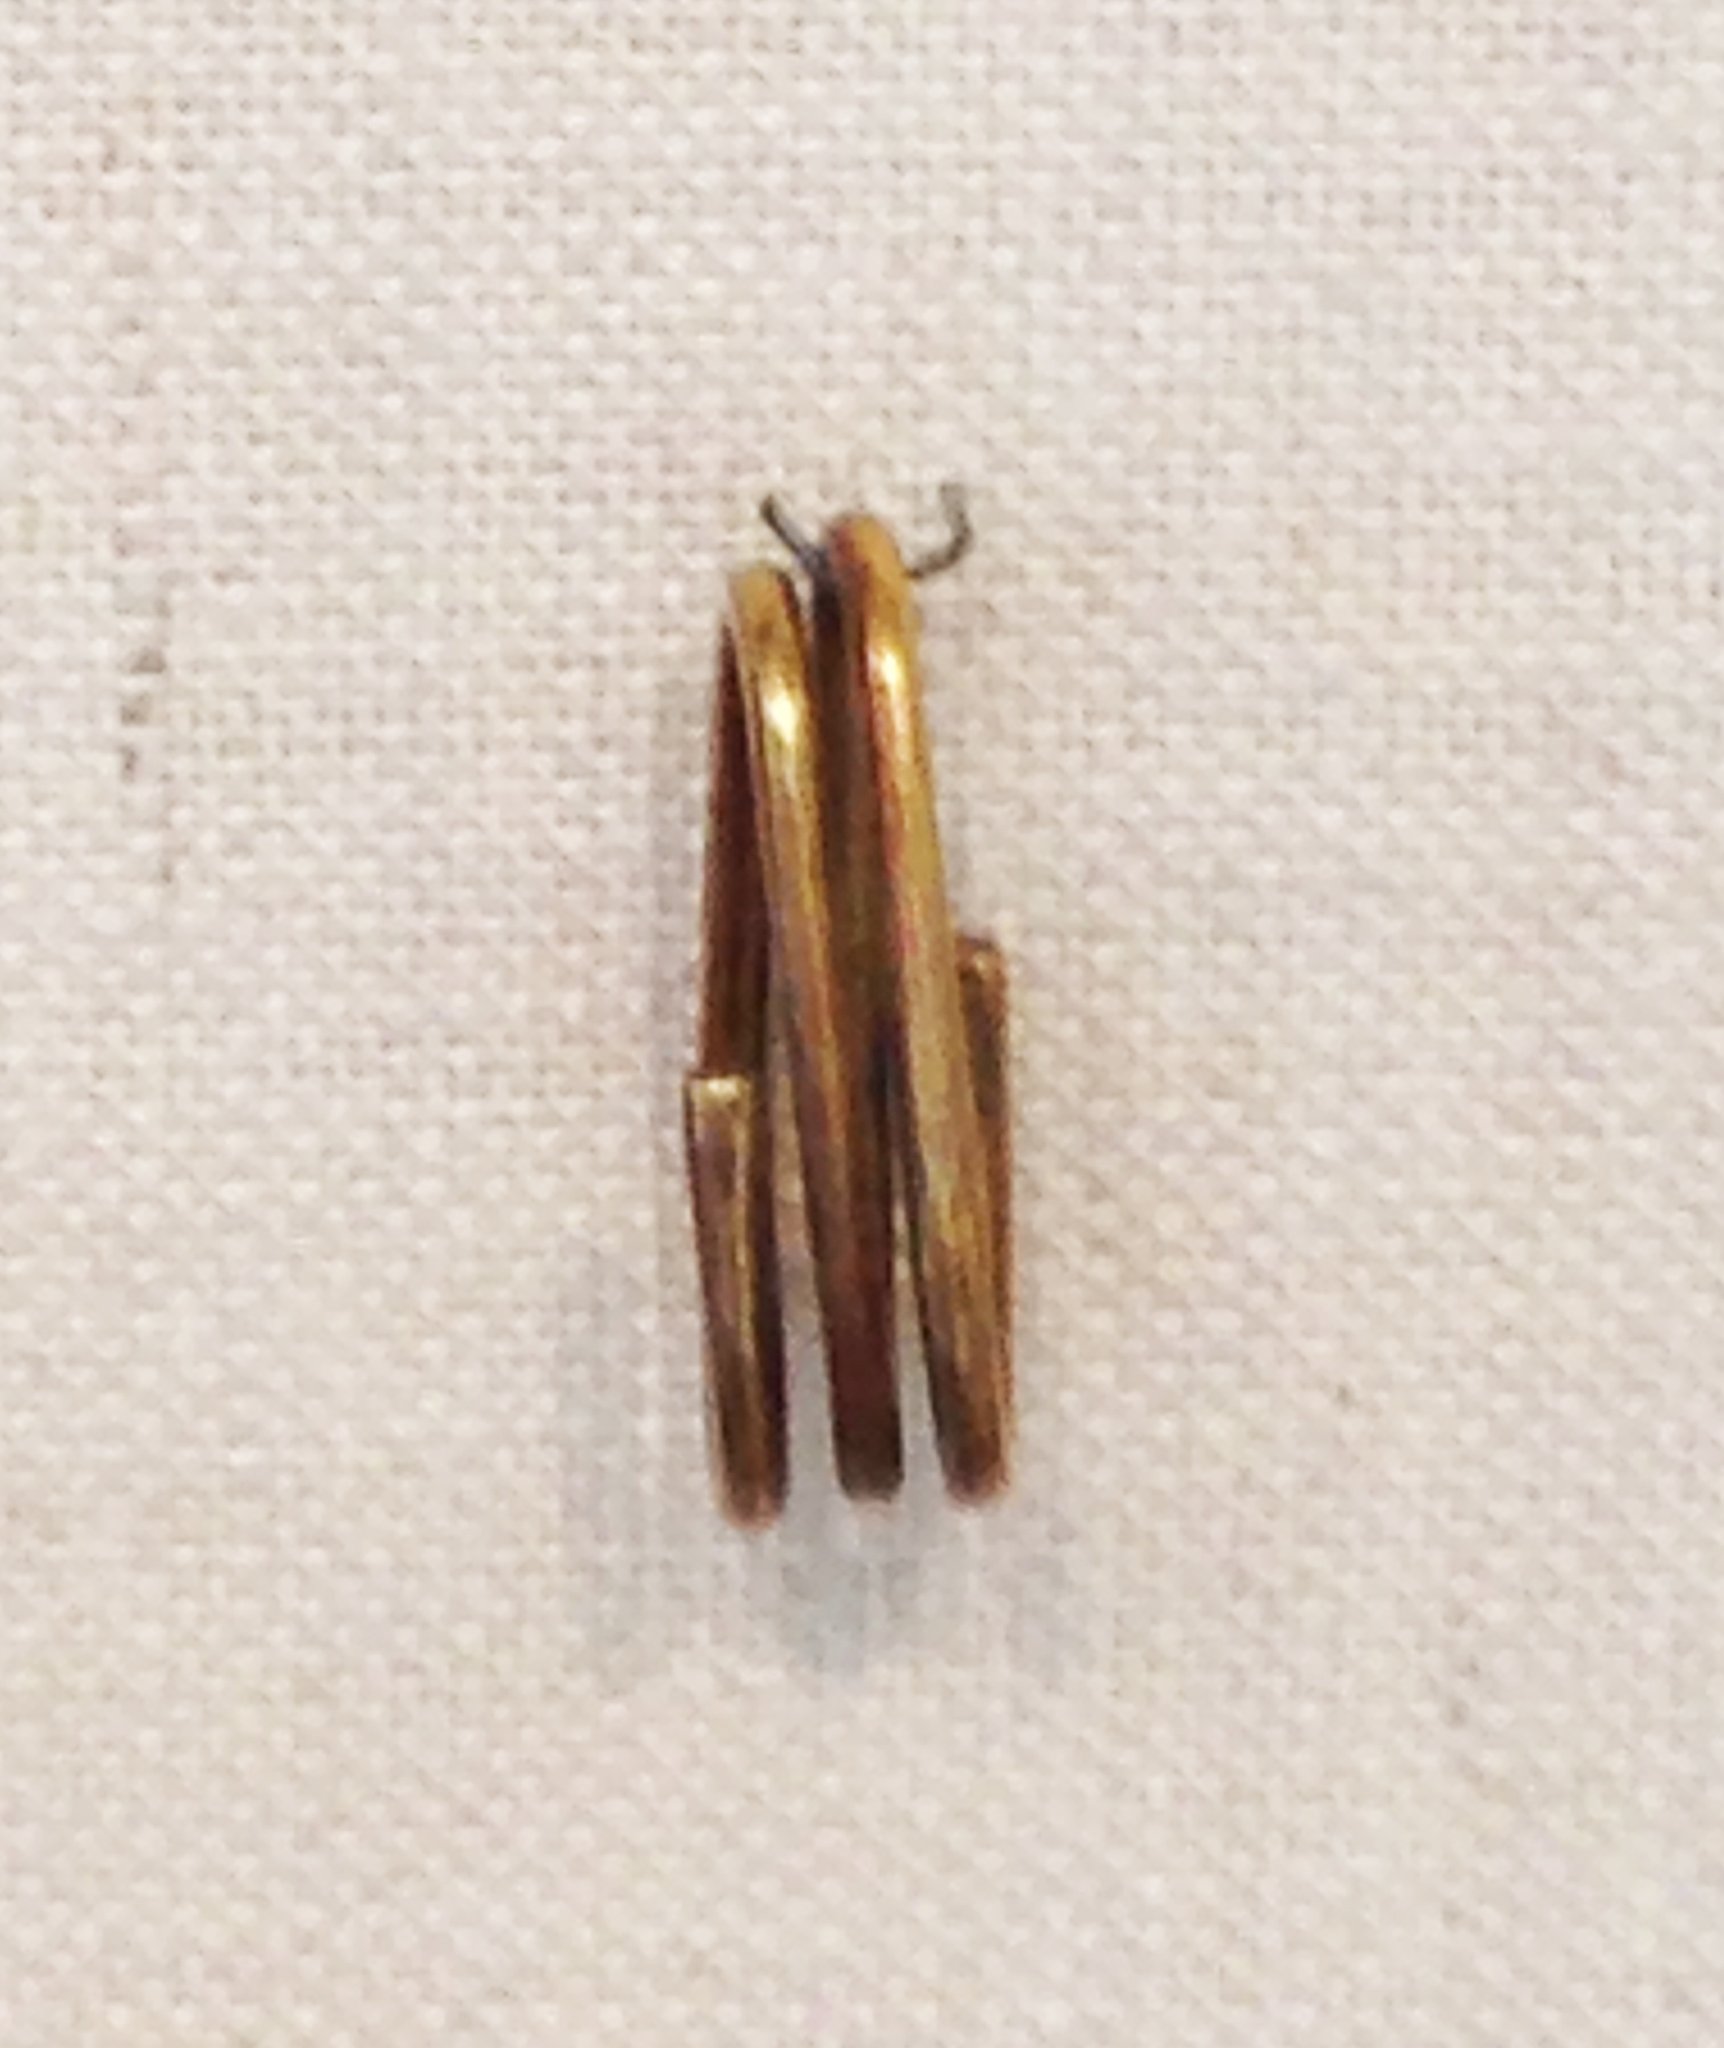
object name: earring or spiral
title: Gold spiral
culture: cypriot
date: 1600-1100 BCE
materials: gold